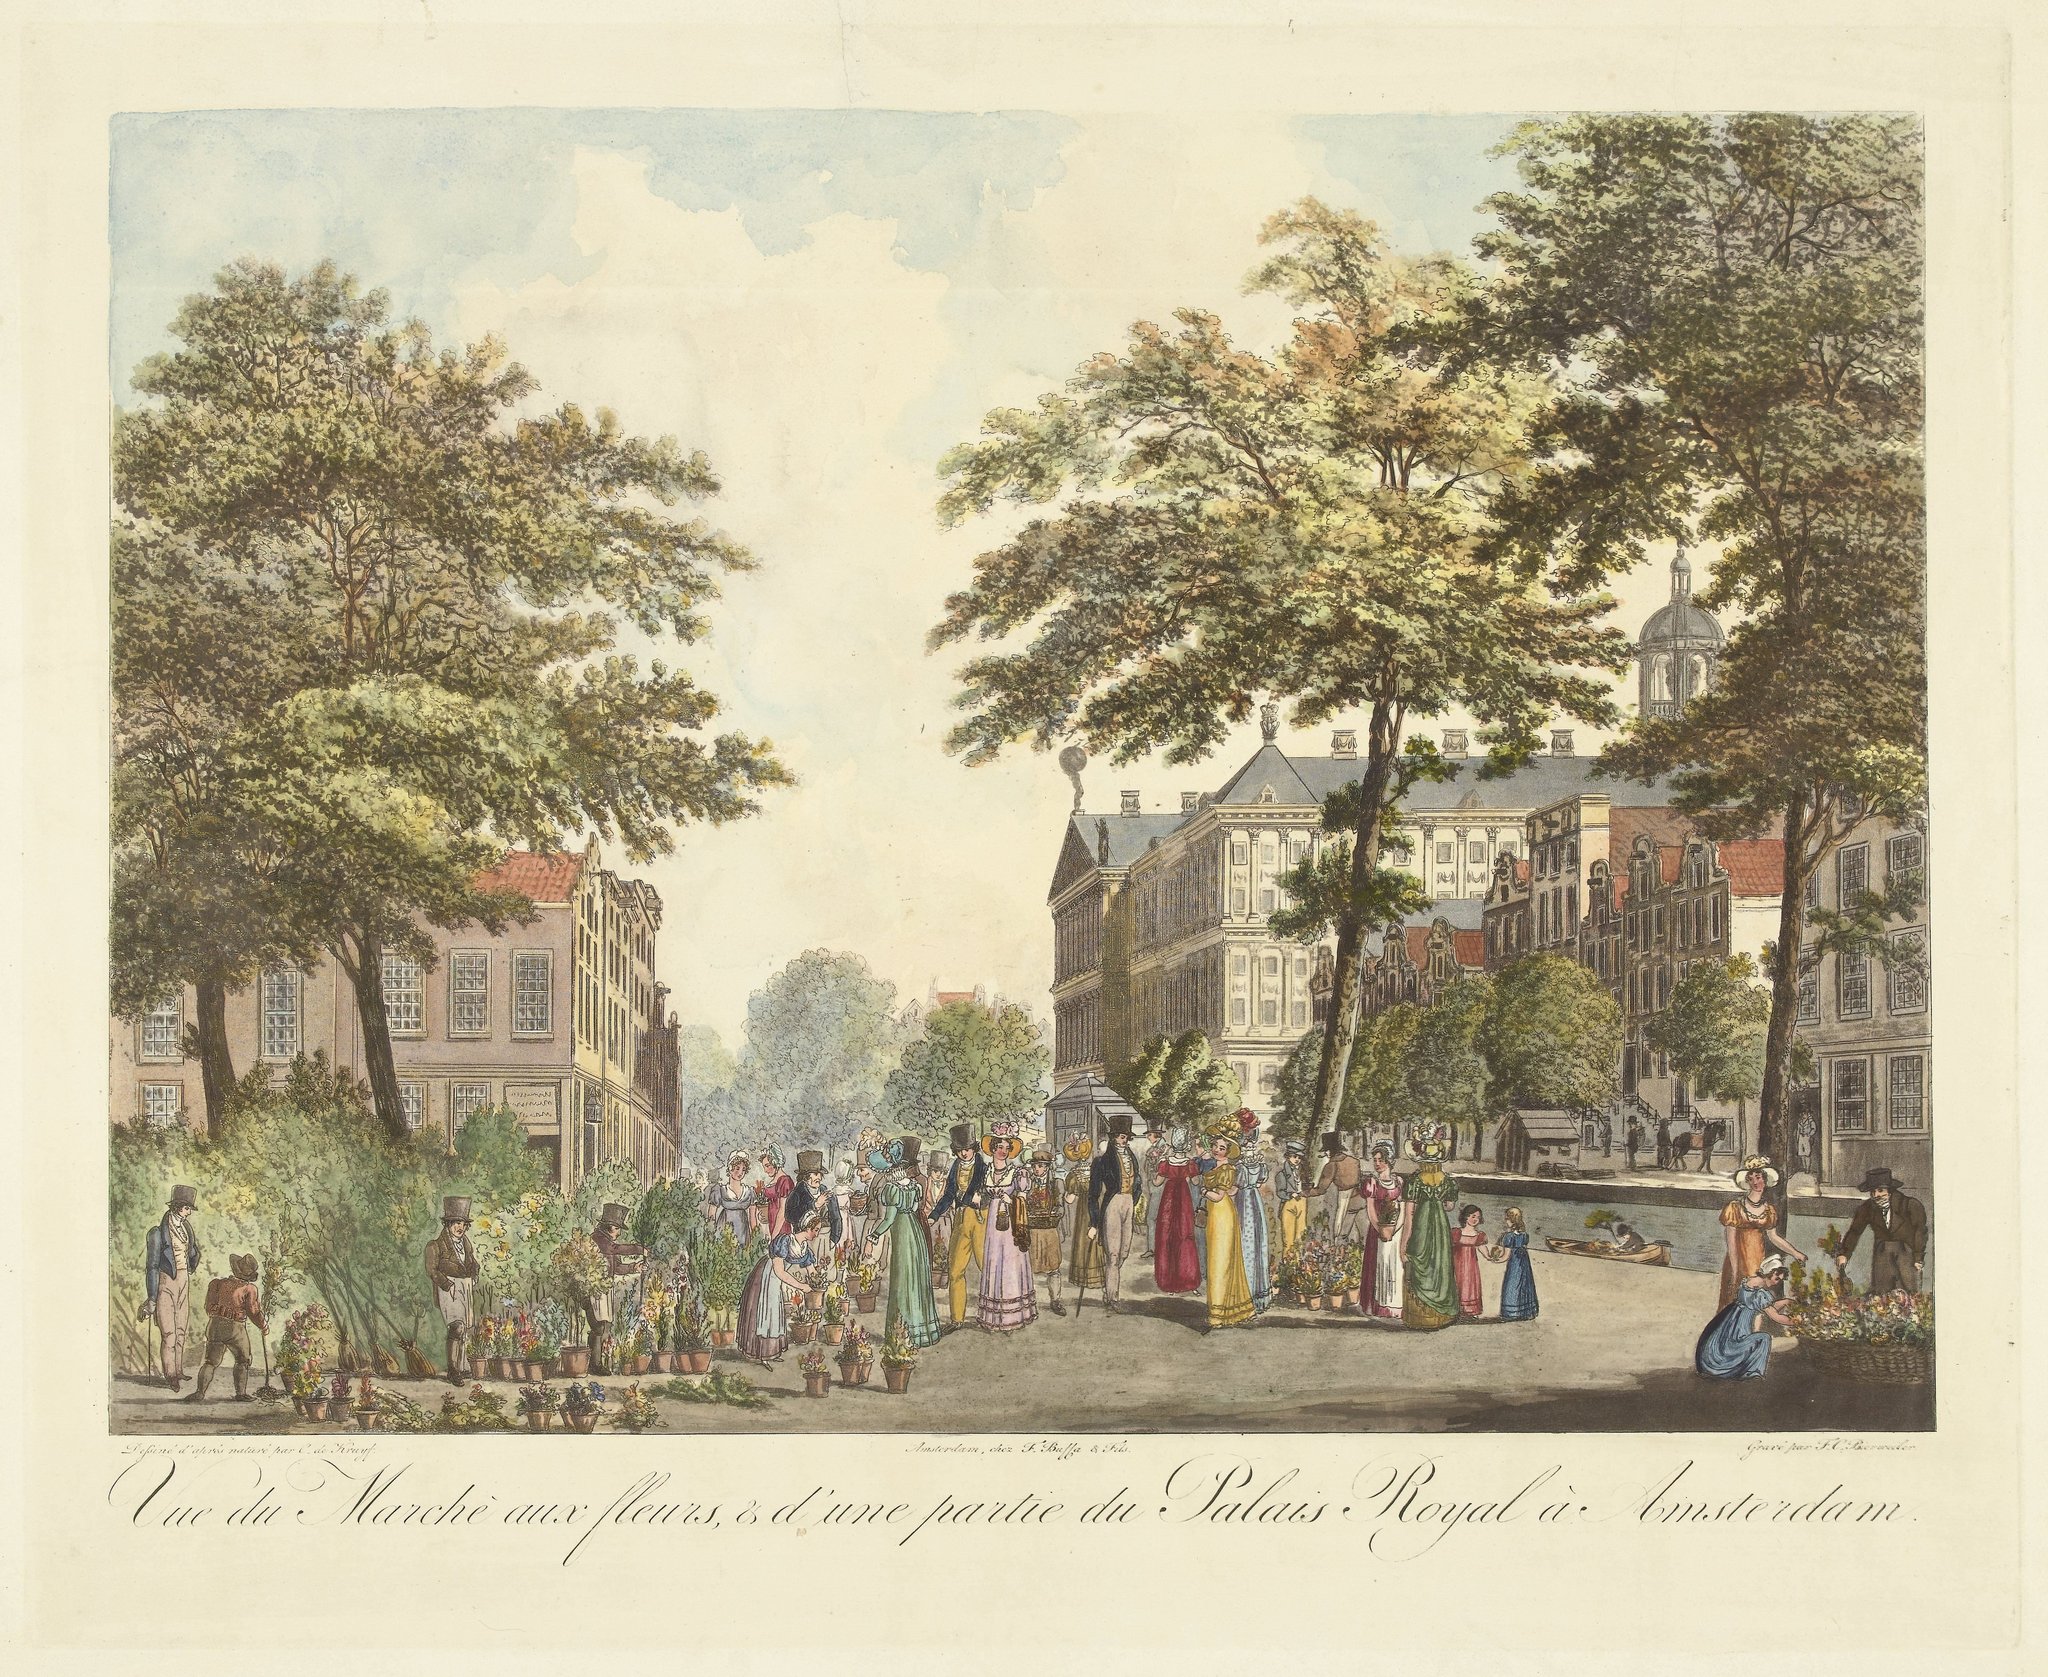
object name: print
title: Vue du Marché aux fleurs, & d'une partie du Palais Royal à Amsterdam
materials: paper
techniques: aquatint, etching, hand coloring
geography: amsterdam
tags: royal palace of amsterdam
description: Gezicht op de bloemenmarkt met bloemenverkopers en klanten, de Nieuwezijds Voorburgwal, en gedeelte van Koninklijk Paleis te Amsterdam.